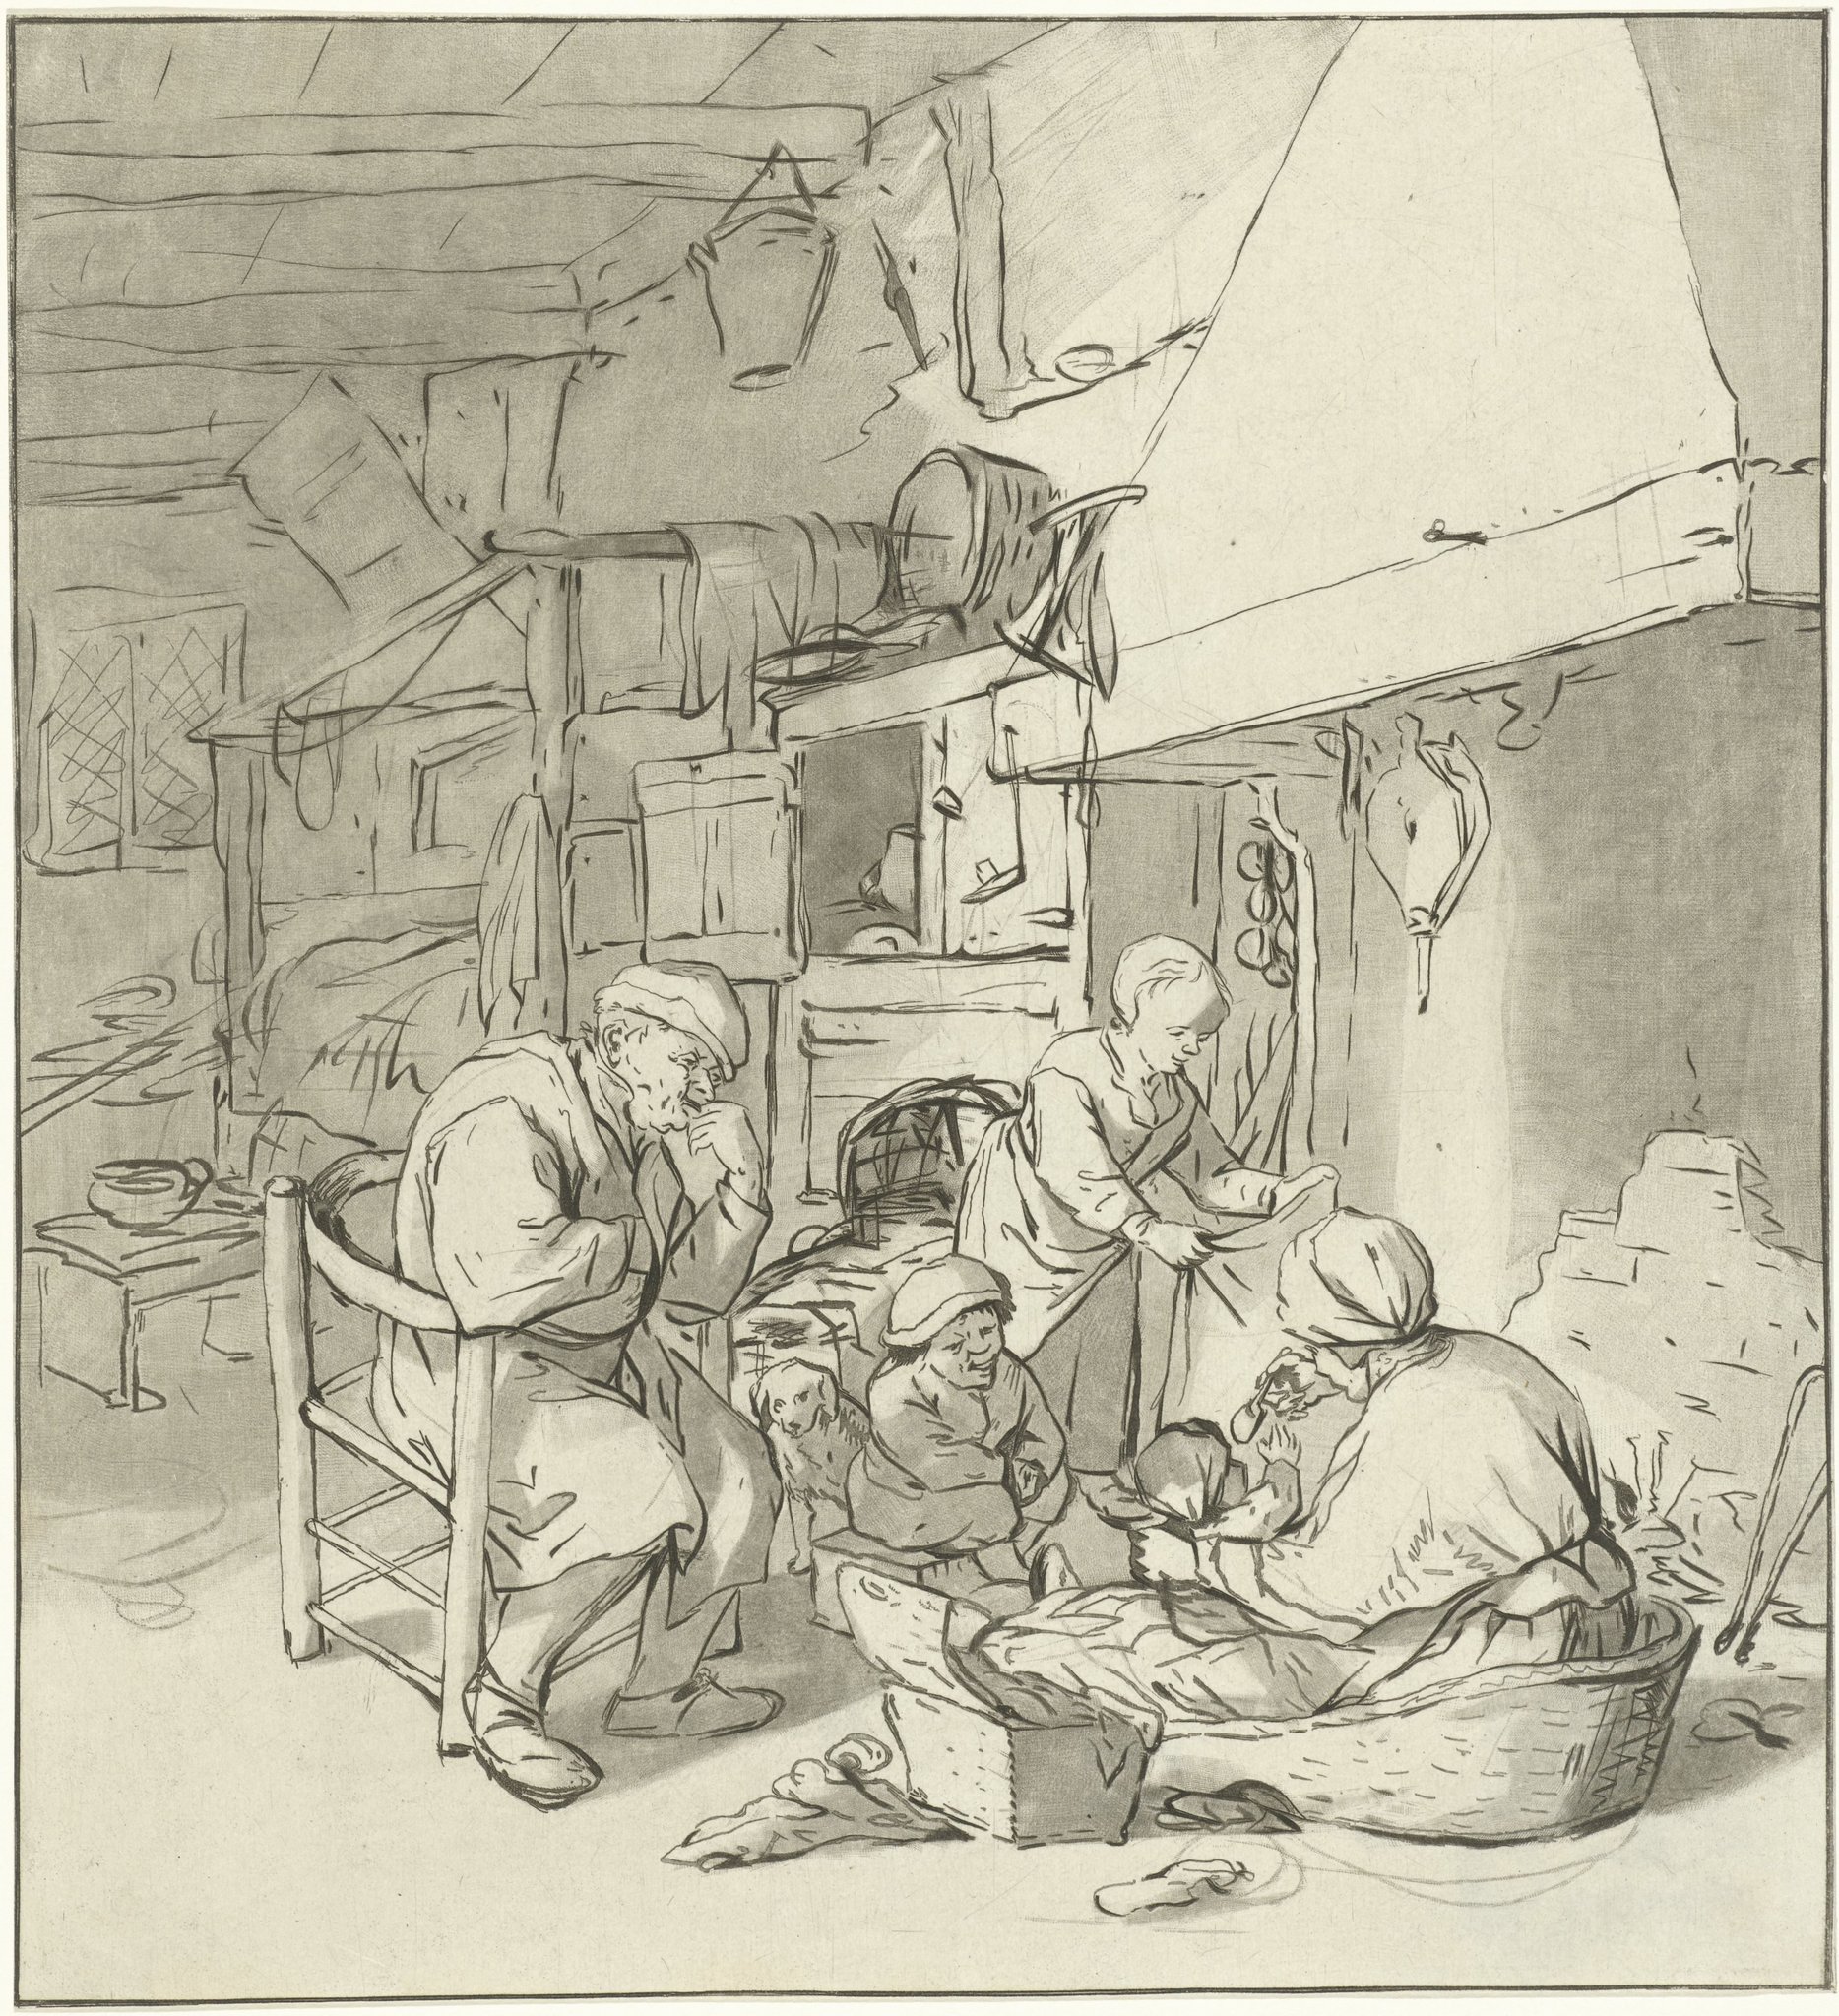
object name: print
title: Boerengezin bij schoorsteen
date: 1767-1821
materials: paper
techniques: etching, roulette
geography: amsterdam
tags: open hearth, fire-place, interior of the house, family life at home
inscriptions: collector's mark: Lugt 2166, collector's mark: Lugt 2725, collector's mark: Lugt 2760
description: Interieur met een gezin rond de schoorsteen. Een moeder voedt haar baby.